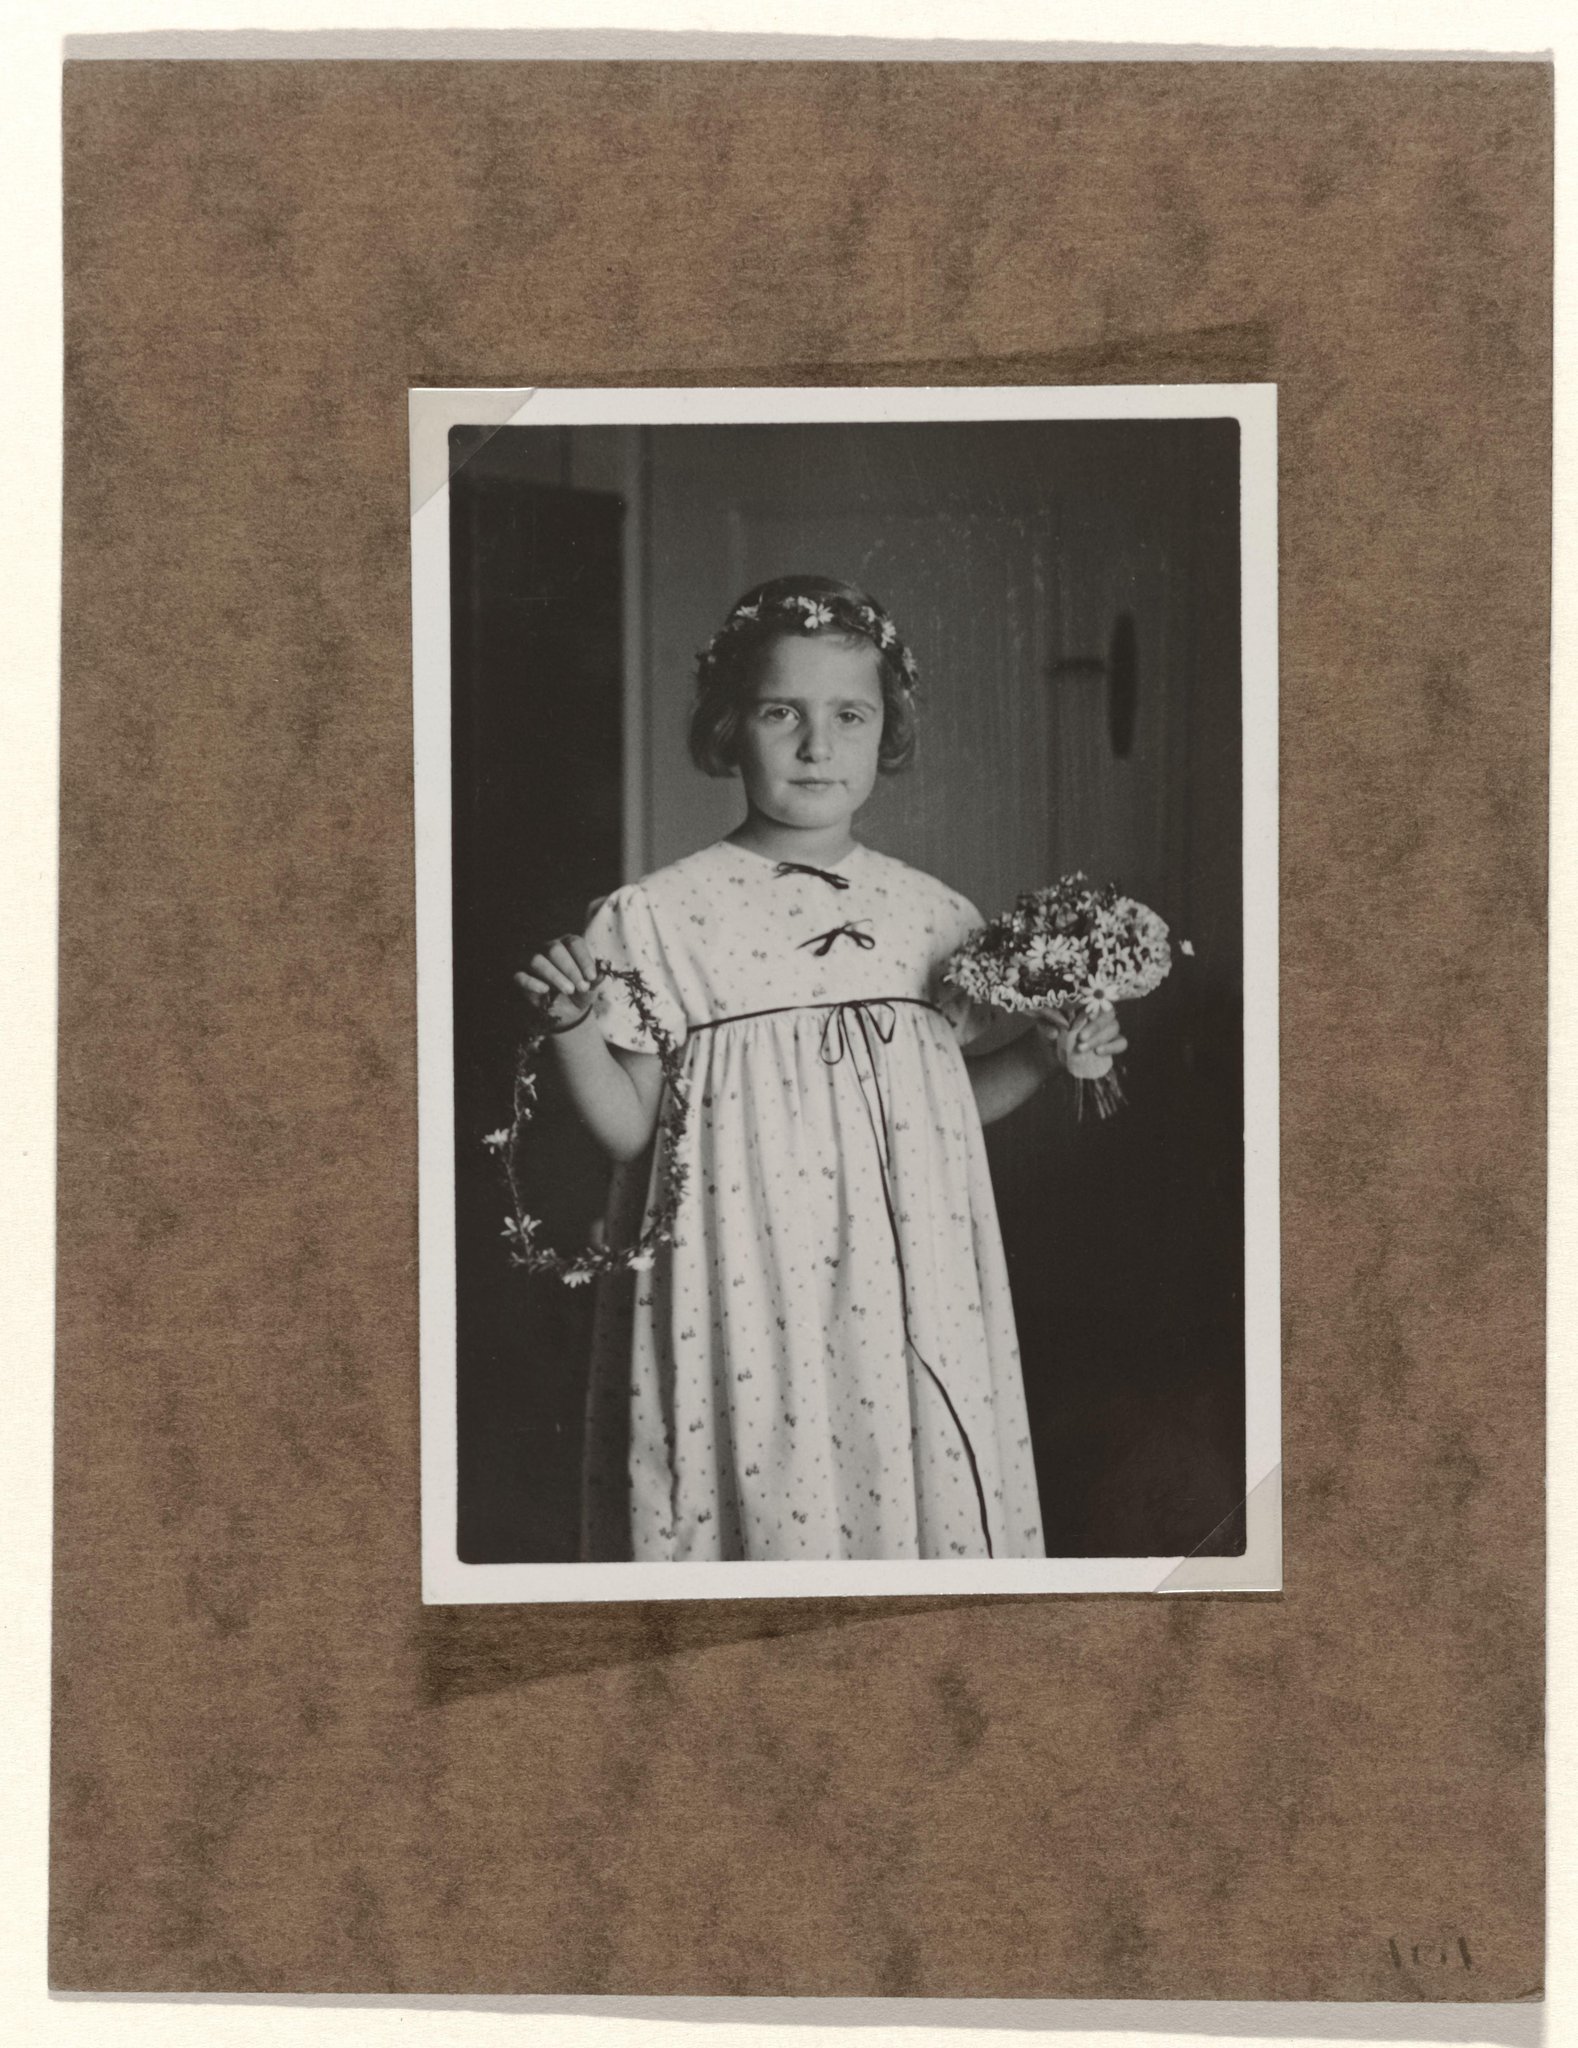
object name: photograph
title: Isabel Wachenheimer met bloemen in haar hand en in het haar tijdens het gouden huwelijksjubileum van Mathilde Wachenheimer-Wertheimer en Meir Wachenheimer, op 22 oktober 1934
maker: Anonymous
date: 1934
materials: photographic support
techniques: gelatin silver print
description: Isabel Wachenheimer met bloemen in haar hand en in het haar. De foto is genomen tijdens het gouden huwelijksjubileum van Isabel's grootouders Mathilde Wachenheimer-Wertheimer en Meir Wachenheimer, op 22 oktober 1934.